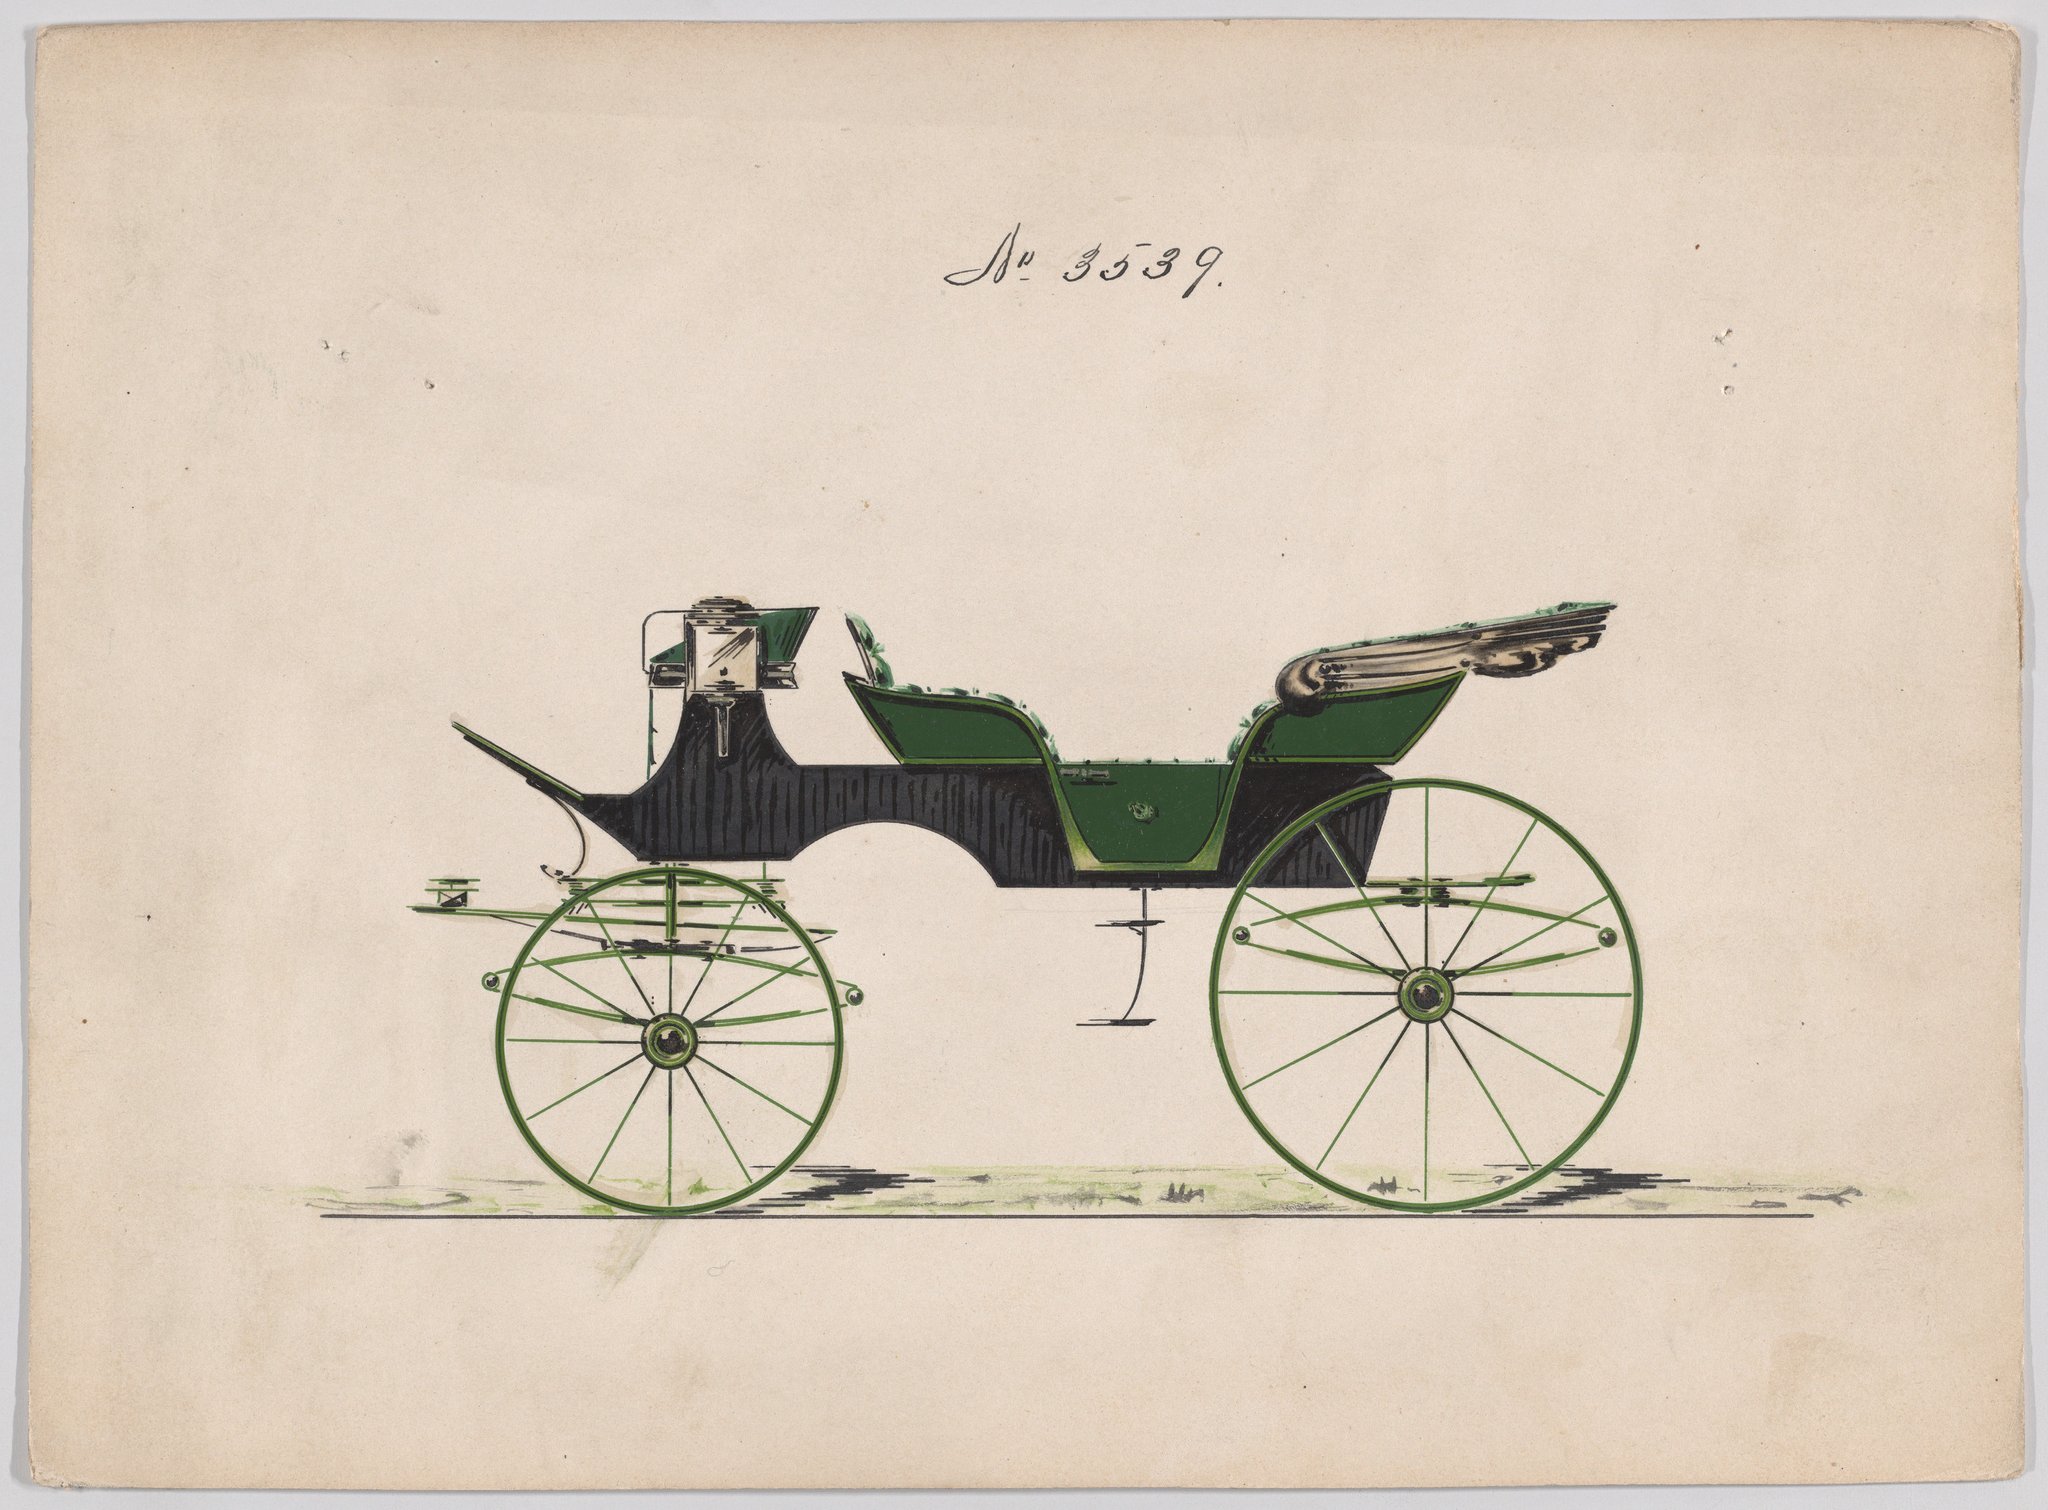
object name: drawing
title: Drag #3539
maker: brewster & co.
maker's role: manufacturer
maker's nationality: american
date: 1879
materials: gouache, gum arabic, ink, watercolor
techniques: pen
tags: carriages